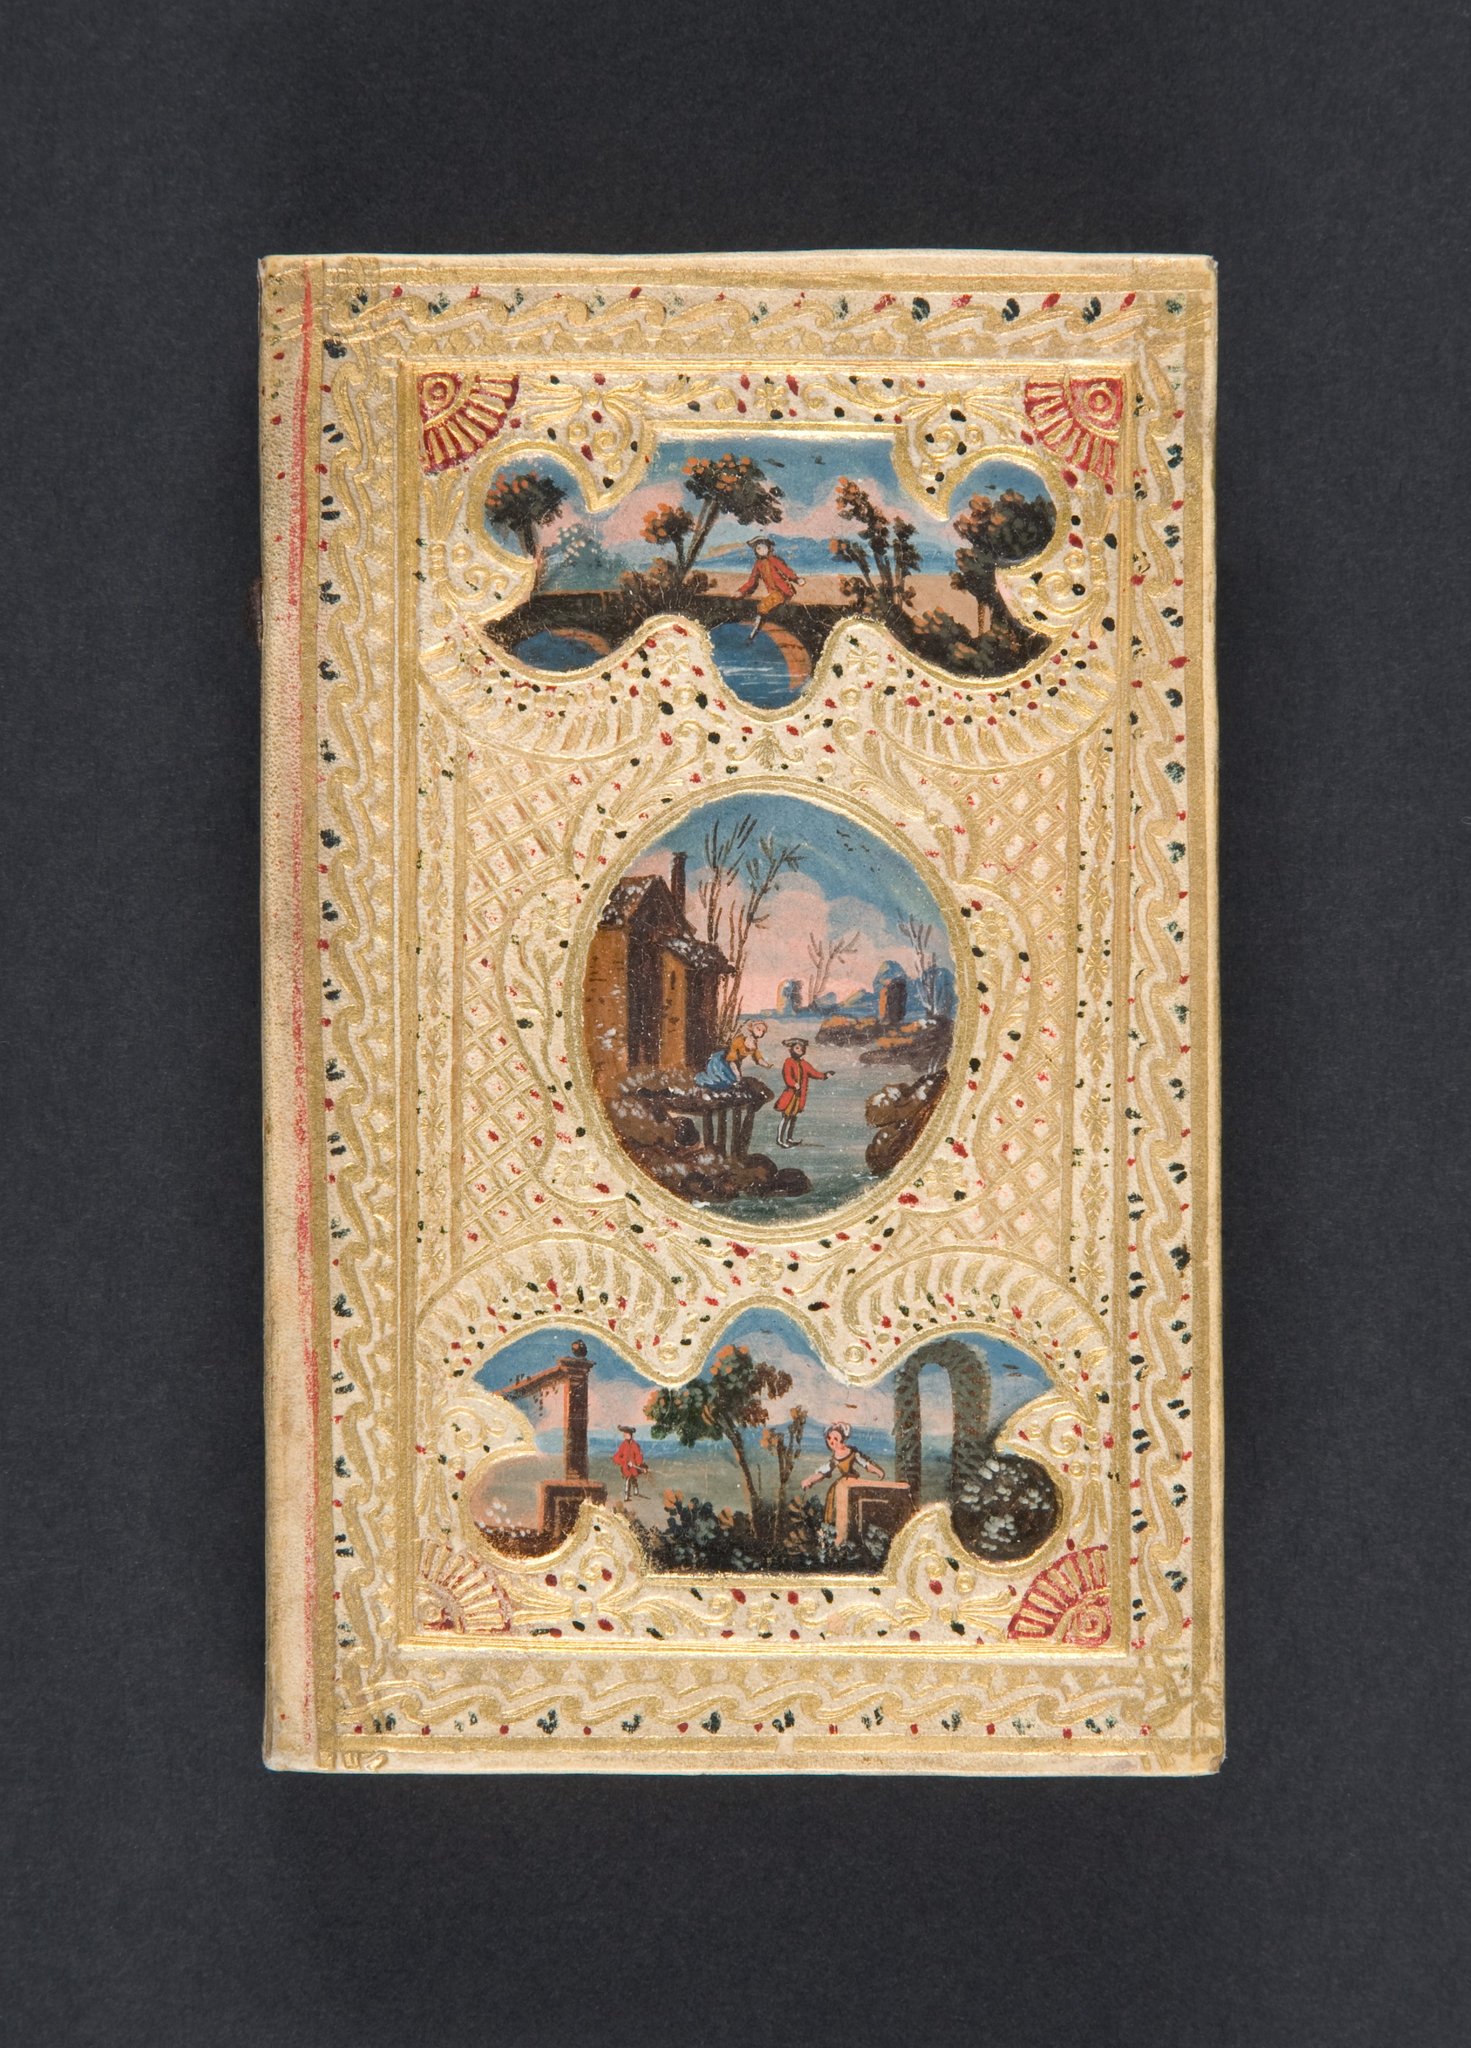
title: Calendrier belgique, curieux et utile, contenant les evenemens historiques sur les jours de l'an, et les travaux à faire dans les jardins en chaque mois de l'année, la description des tableaux remarquables, que l'on trouve dans la ville de Gand, avec les noms des peintres pour l'annėe MDCCLXXII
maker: pierre de goesin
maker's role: publisher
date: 1772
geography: belgium